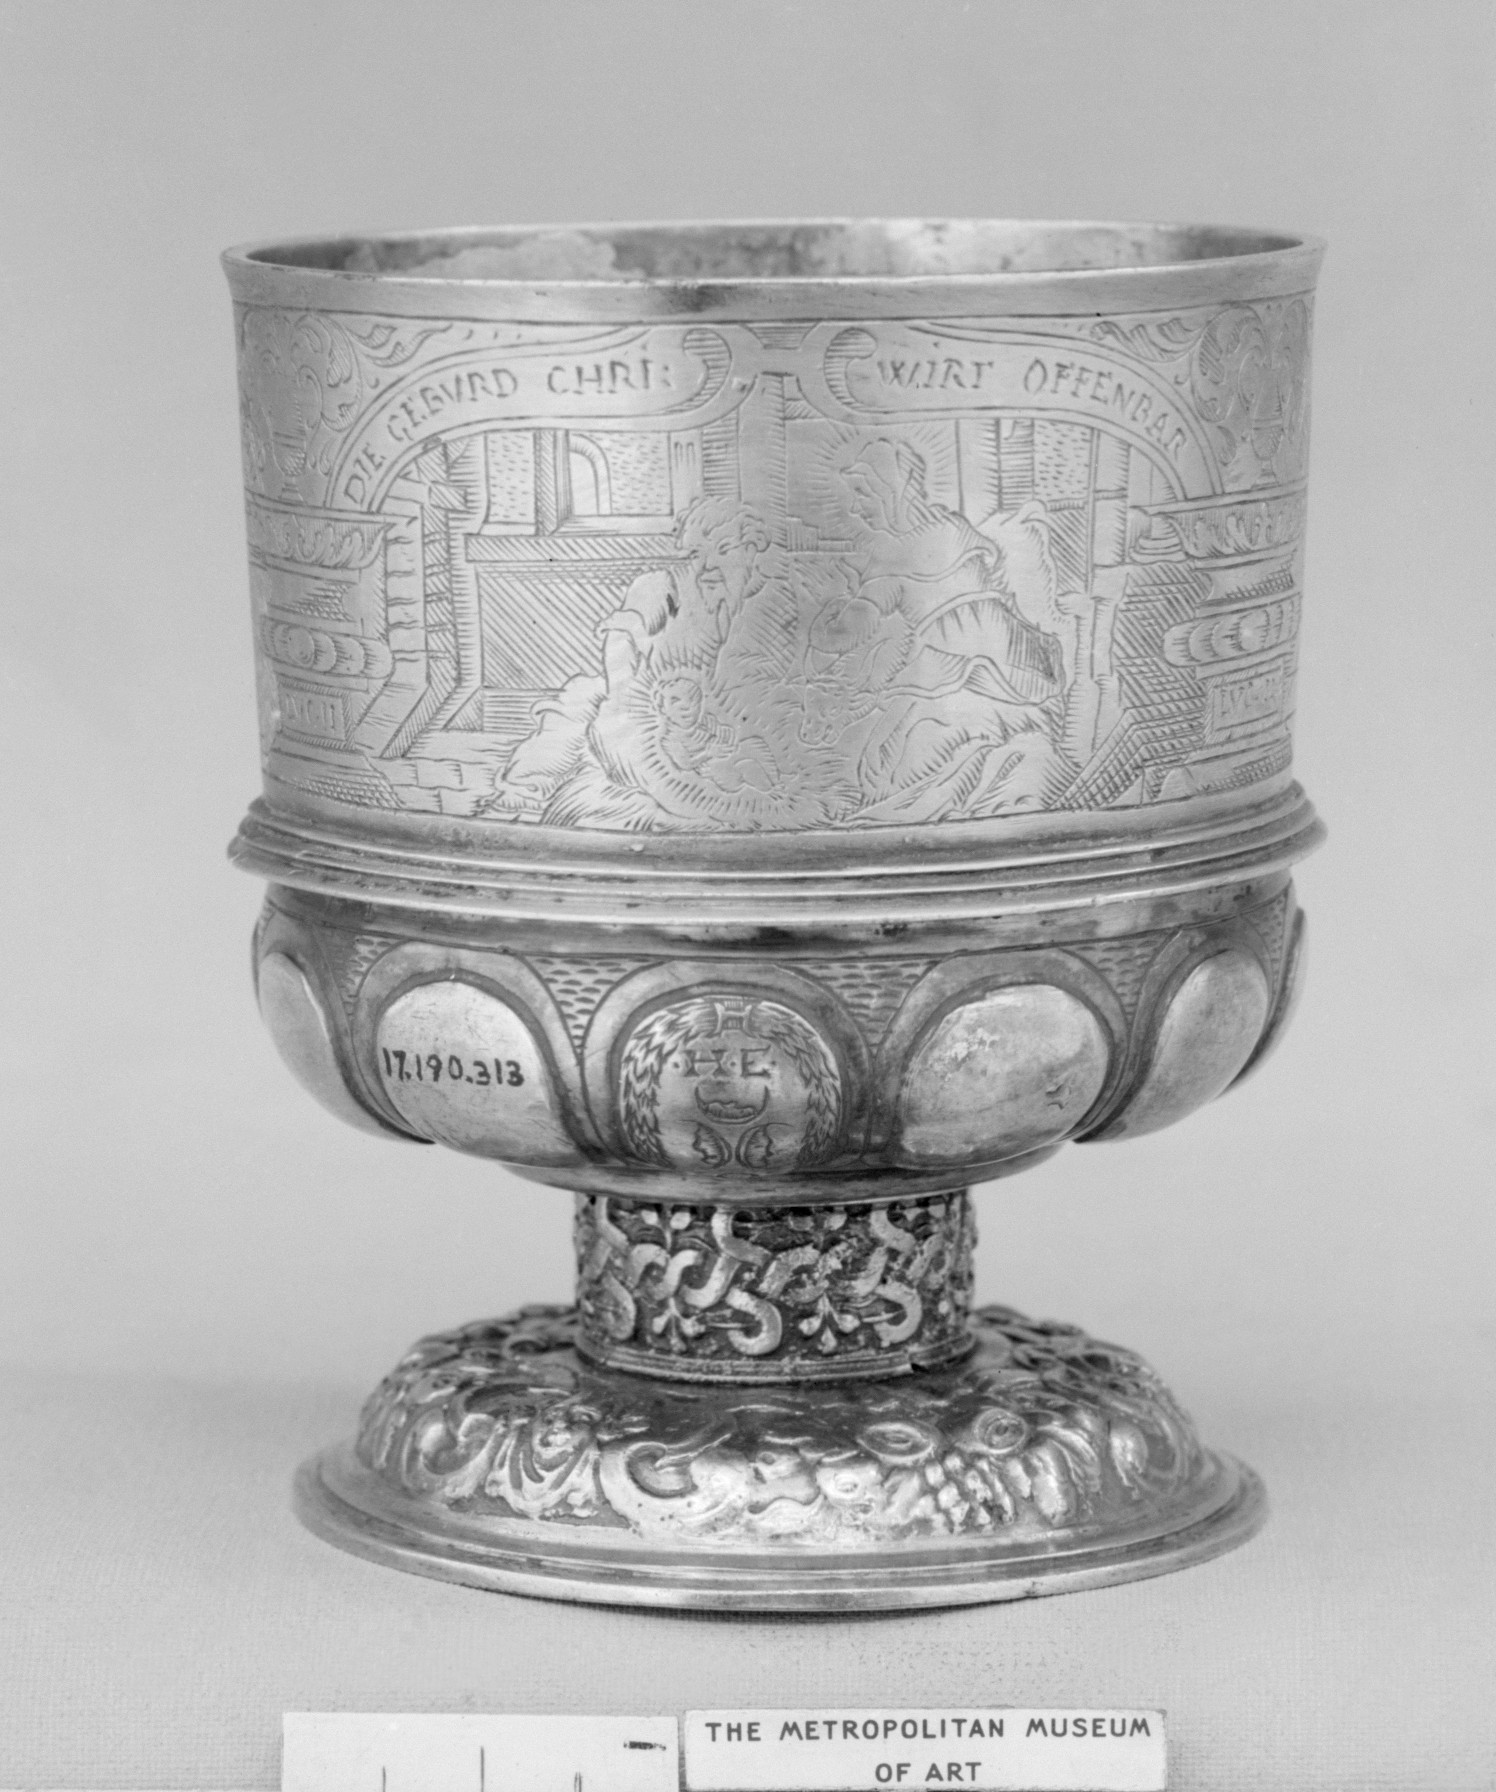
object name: cup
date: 1601-1700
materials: gilt, silver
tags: insignia